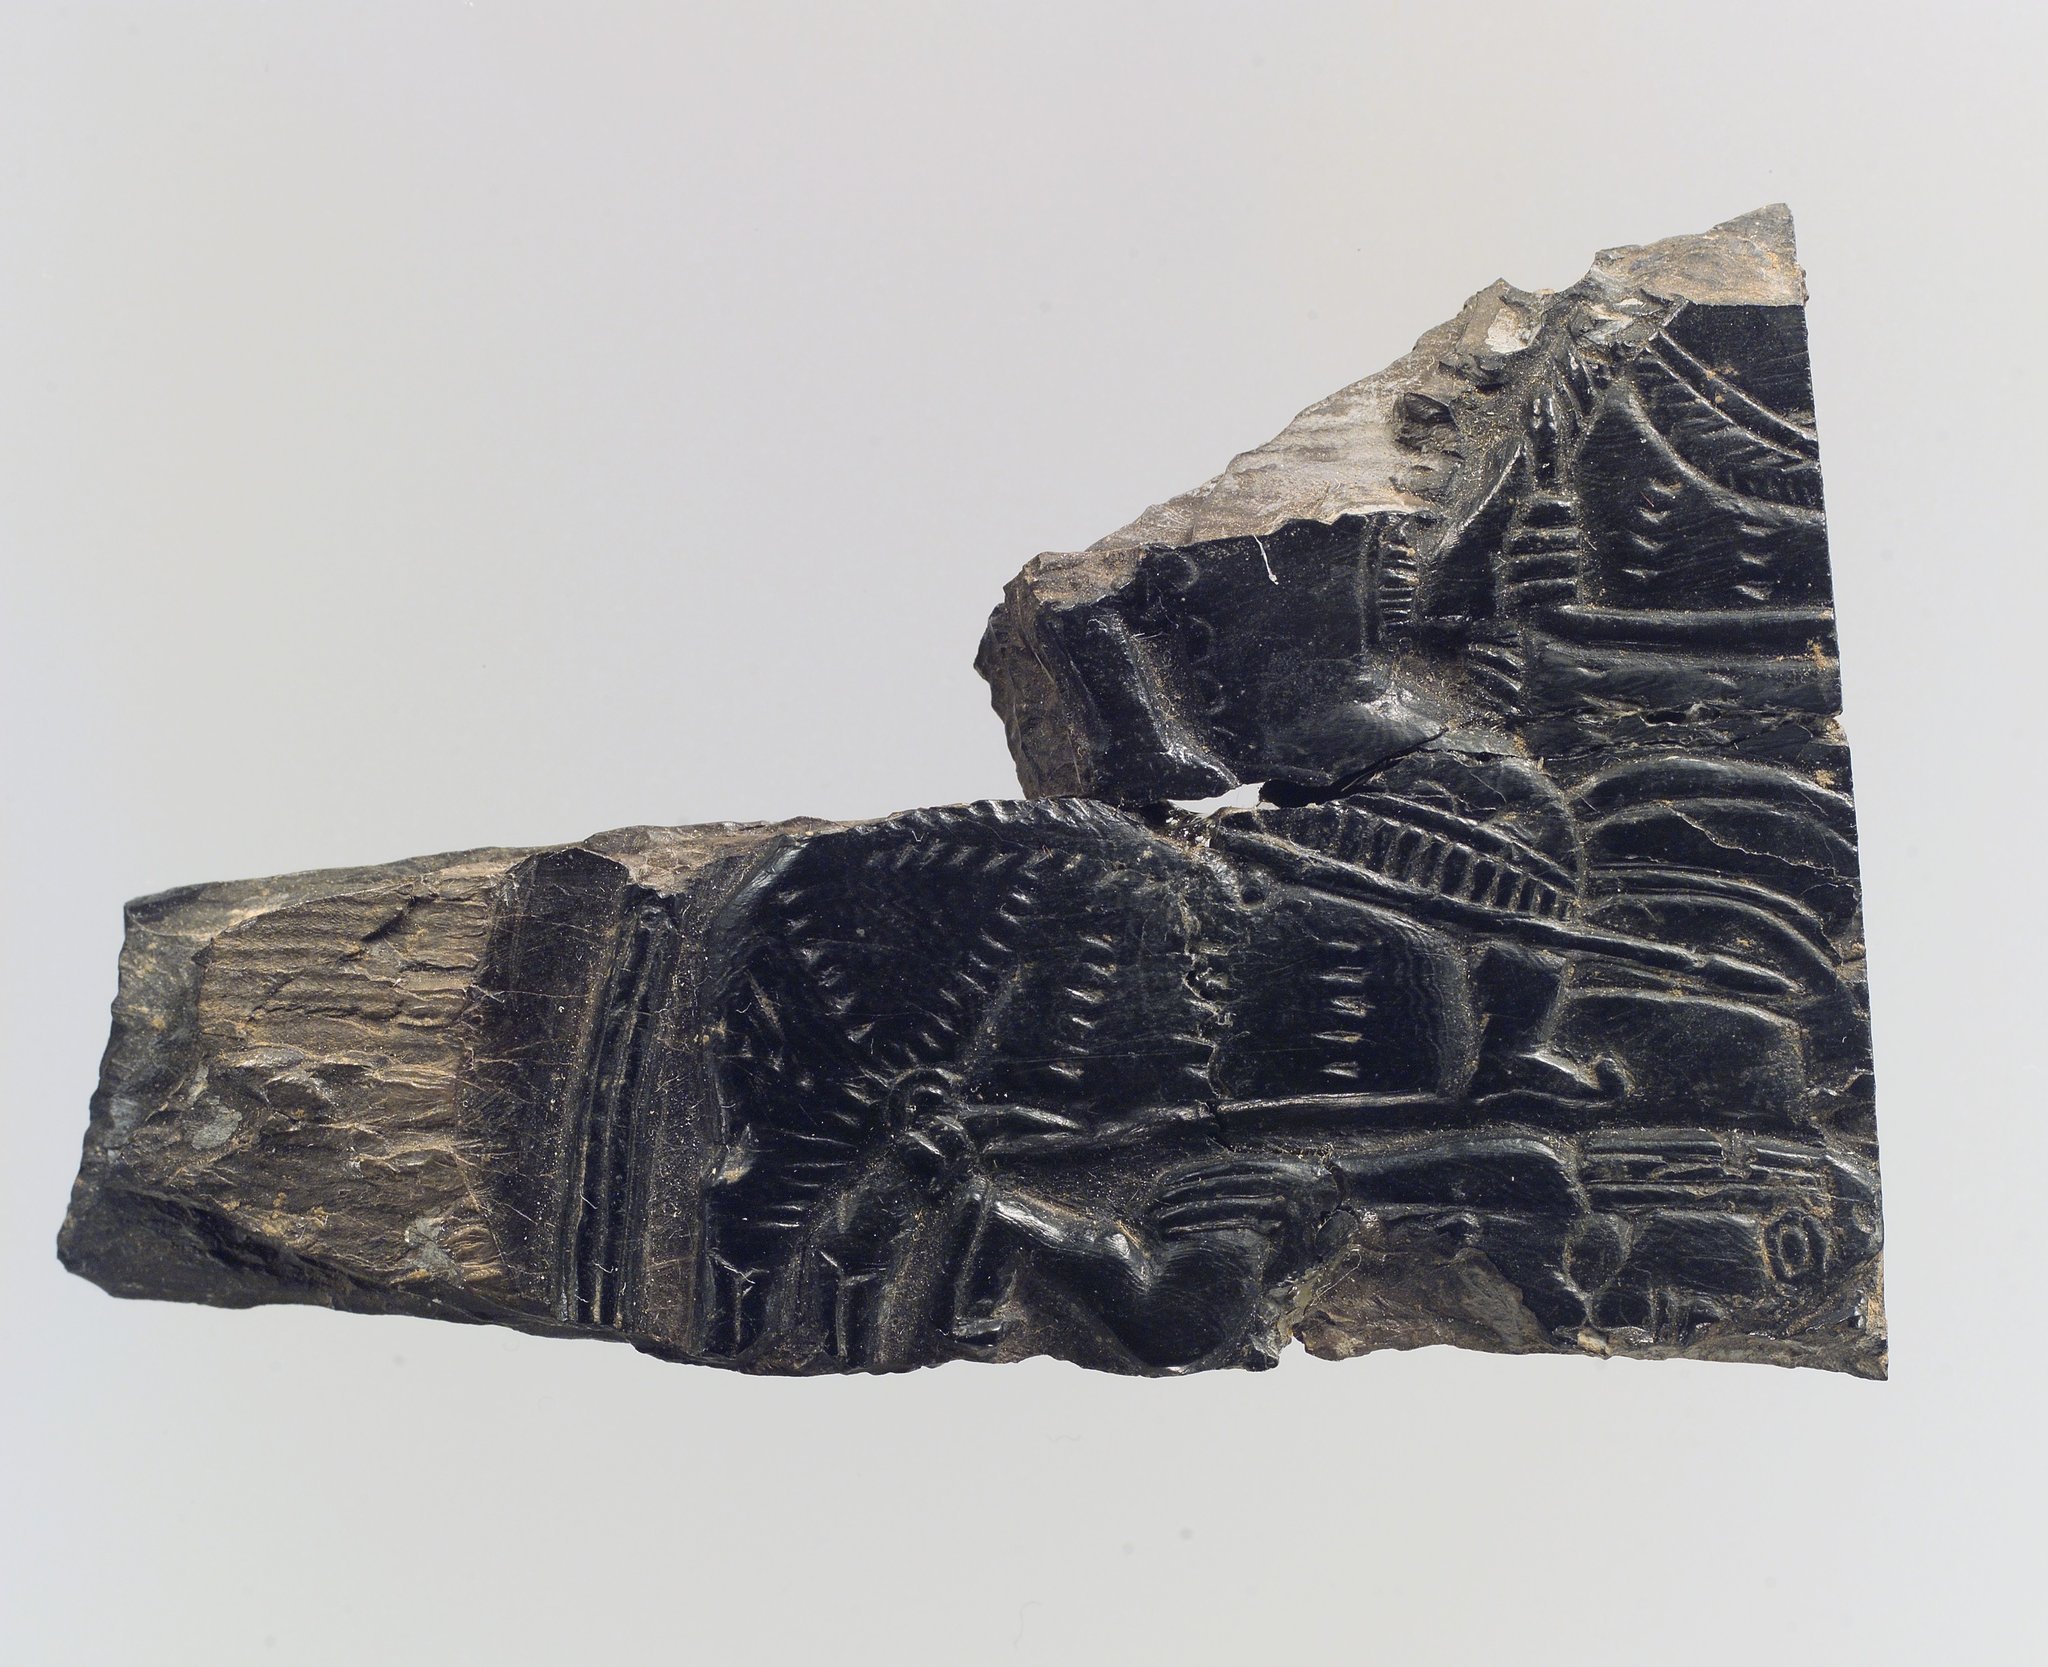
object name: relief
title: Plaque fragment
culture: iranian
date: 900-801 BCE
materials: ivory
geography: iran